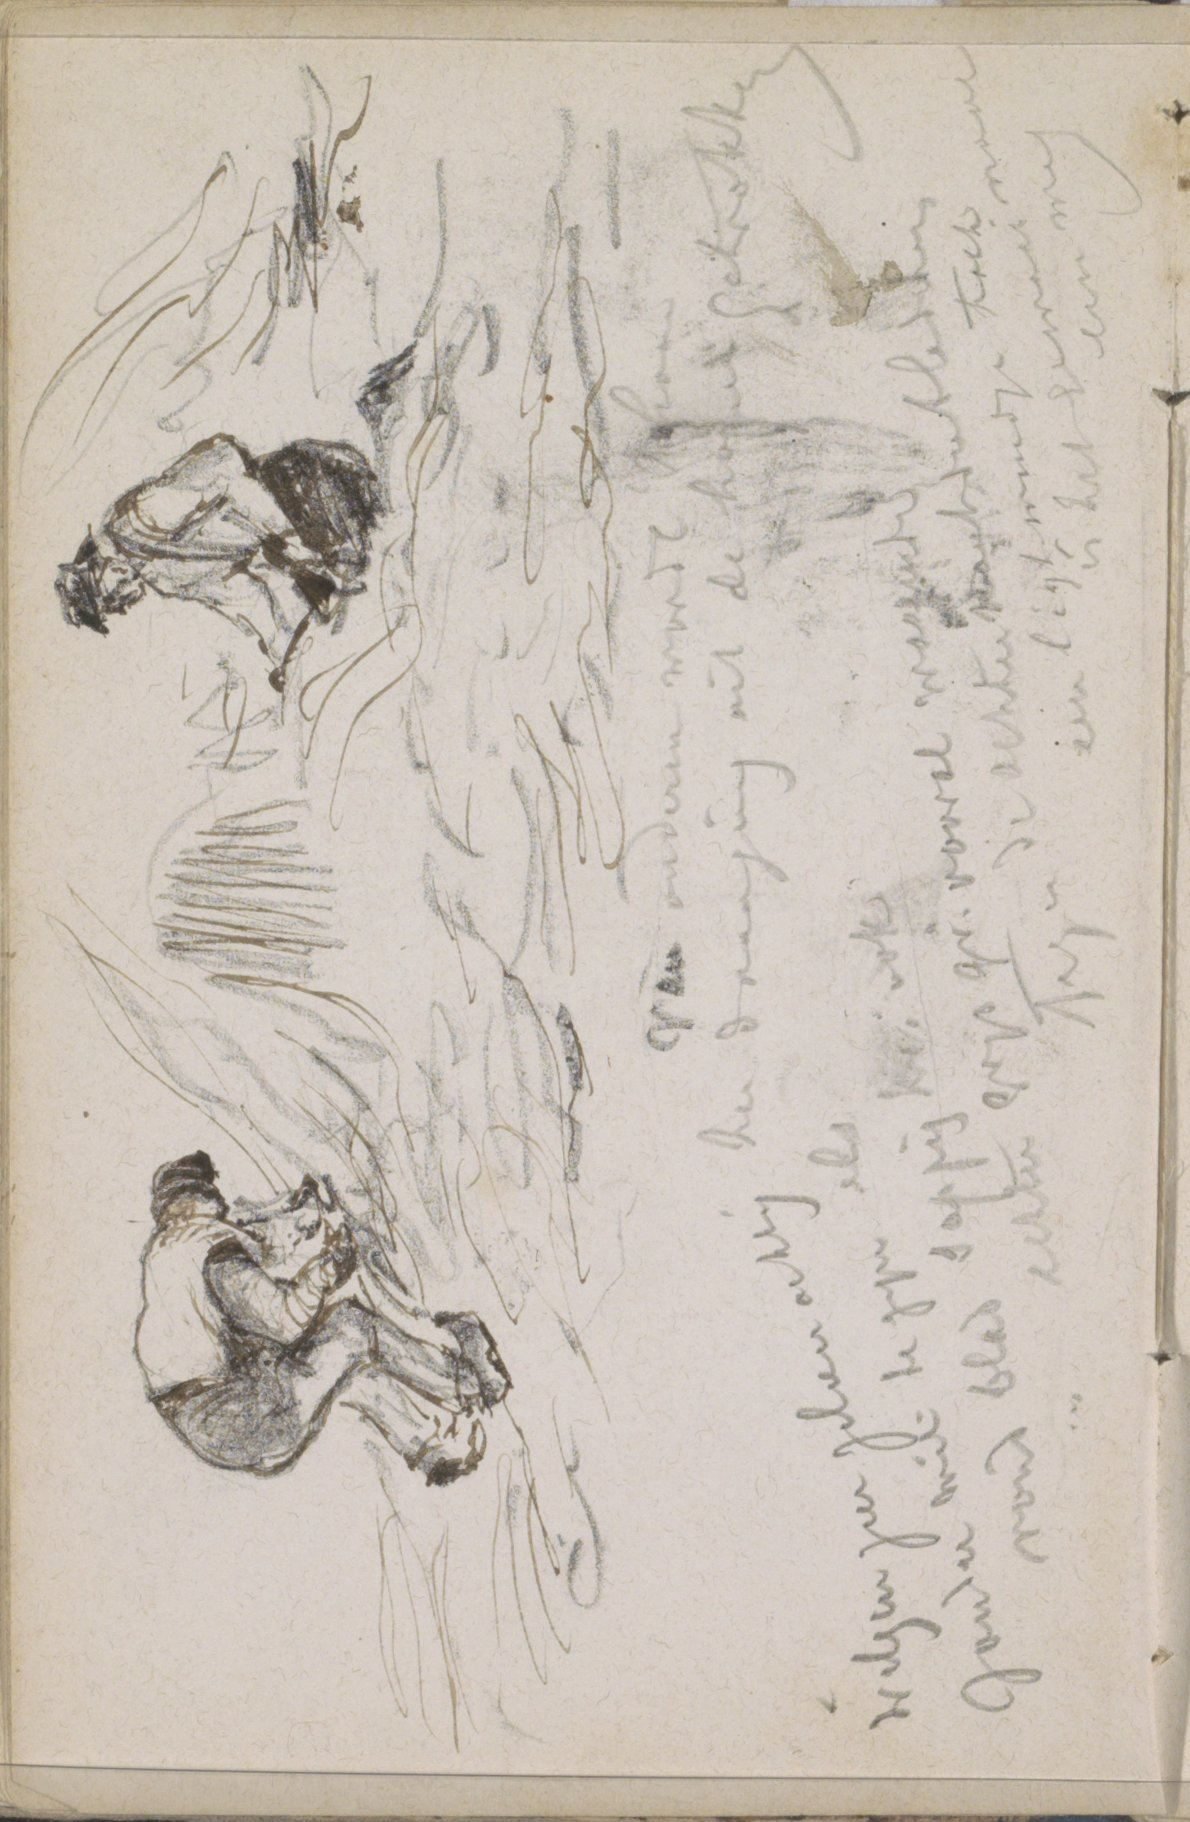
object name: sketchbook leaf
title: Landwerkers in het hooi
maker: johannes tavenraat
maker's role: draughtsman, painter, print maker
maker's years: 1809-1881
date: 1862-1864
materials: ink, paper, pencil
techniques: pen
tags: harvest, agricultural products and by-products: hay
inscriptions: kleurnotitie, handgeschreven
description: Blad 10 verso uit een schetsboek met 65 bladen.